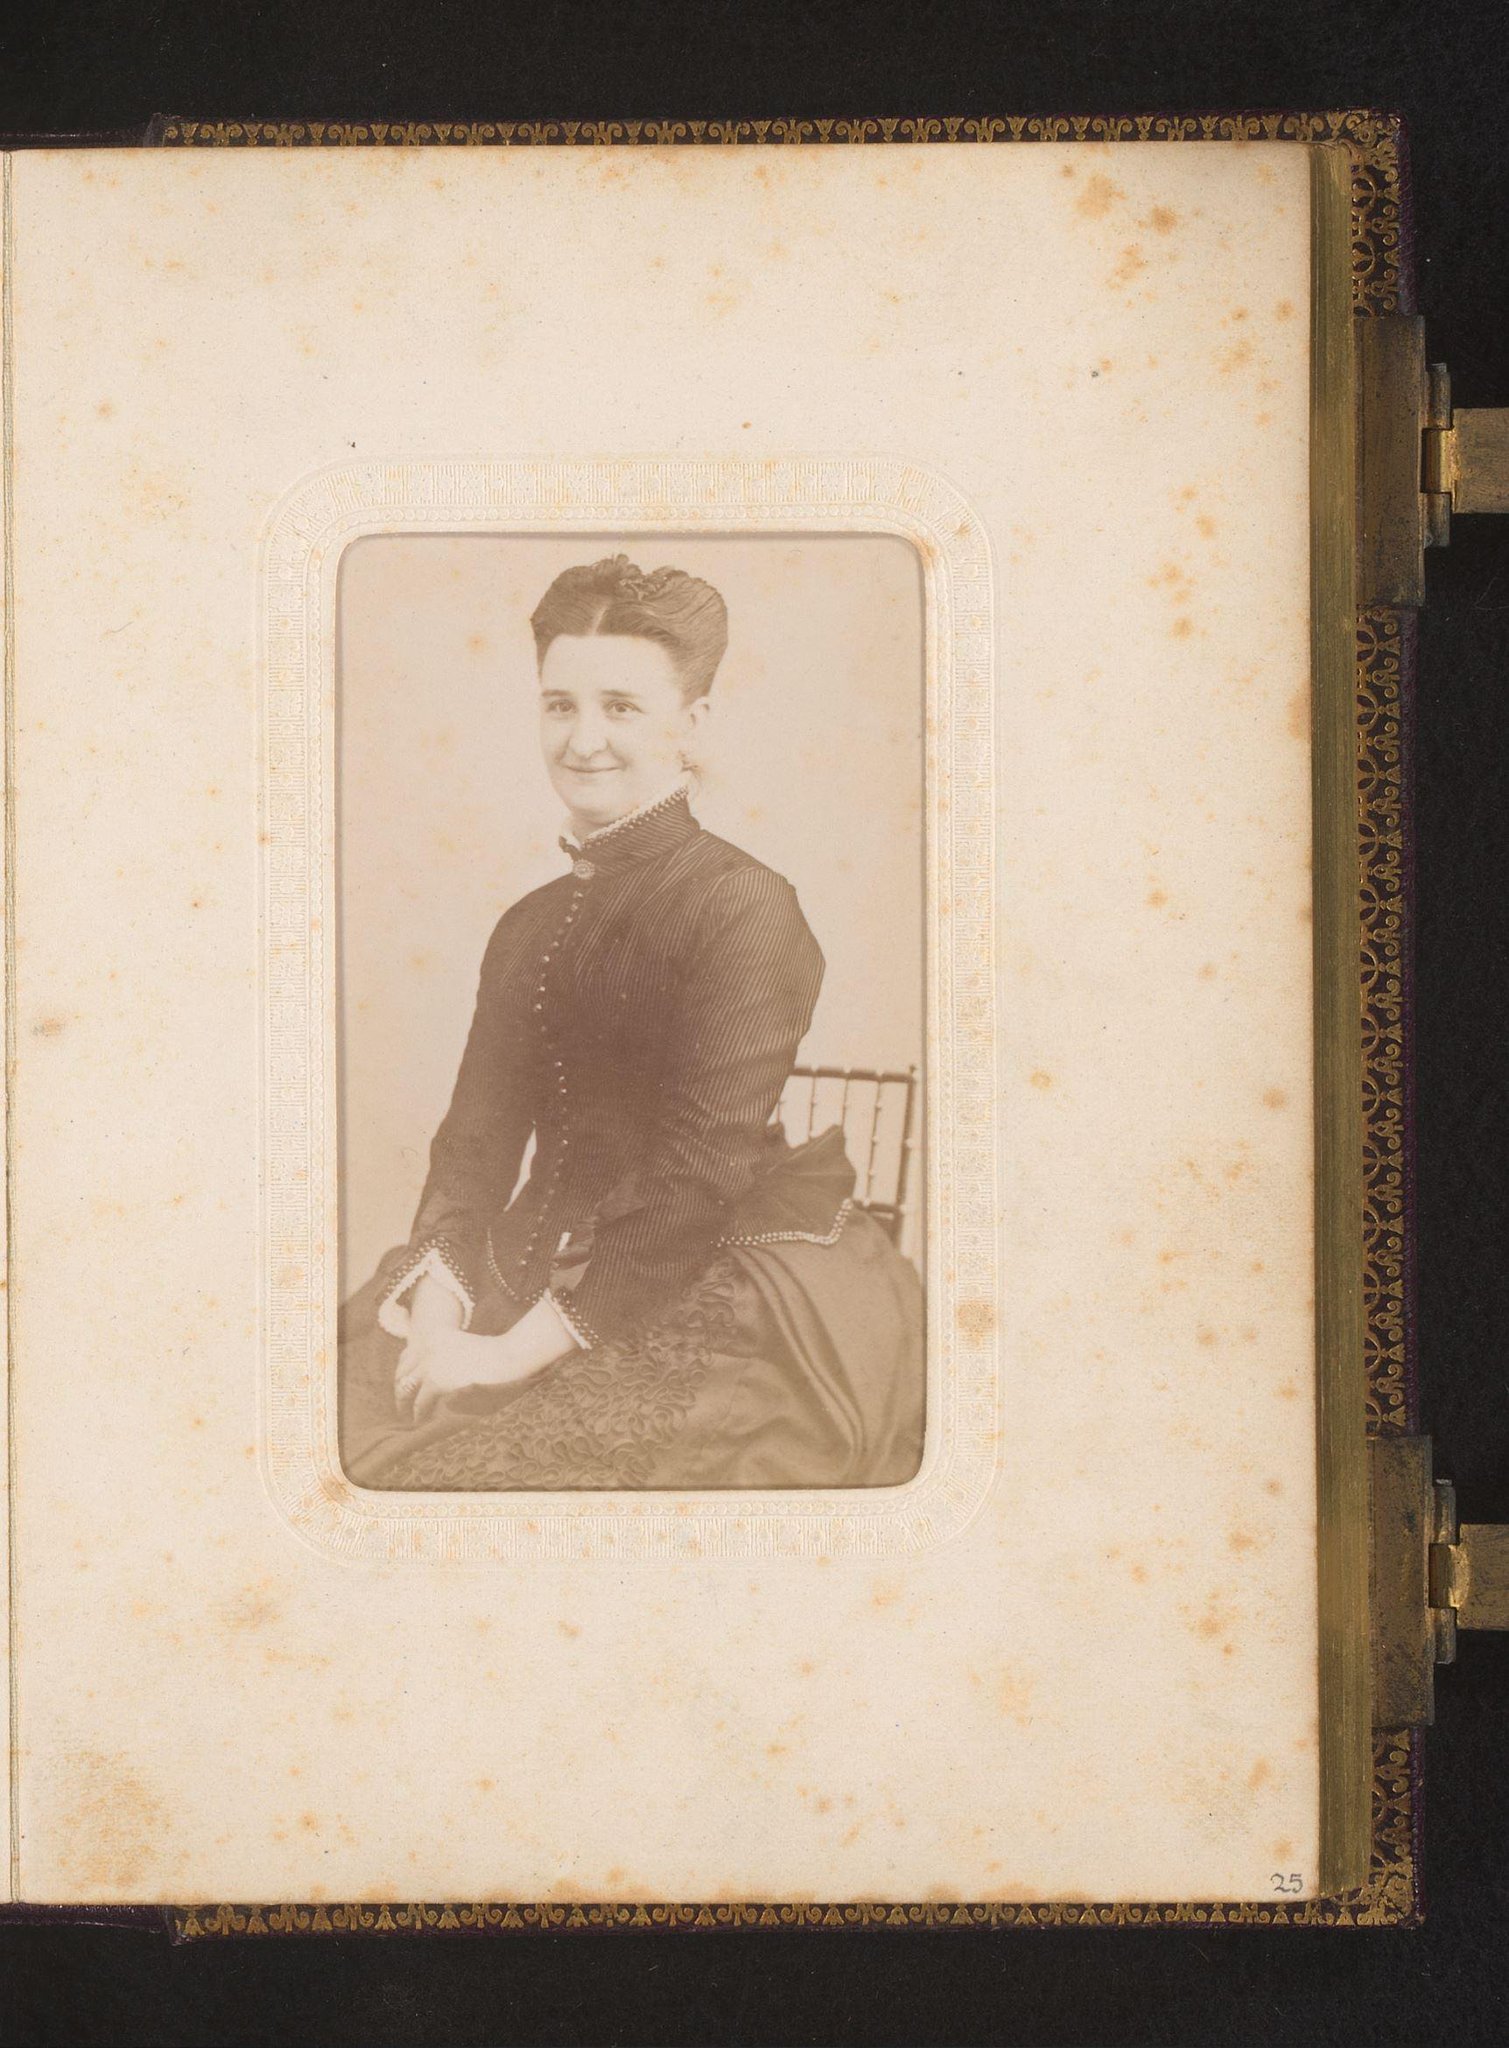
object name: photograph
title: Portret van een zittende vrouw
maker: Anonymous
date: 1860-1900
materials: cardboard, photographic support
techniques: albumen print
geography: france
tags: sitting figure - aa - female human figure, historical persons - bb - woman